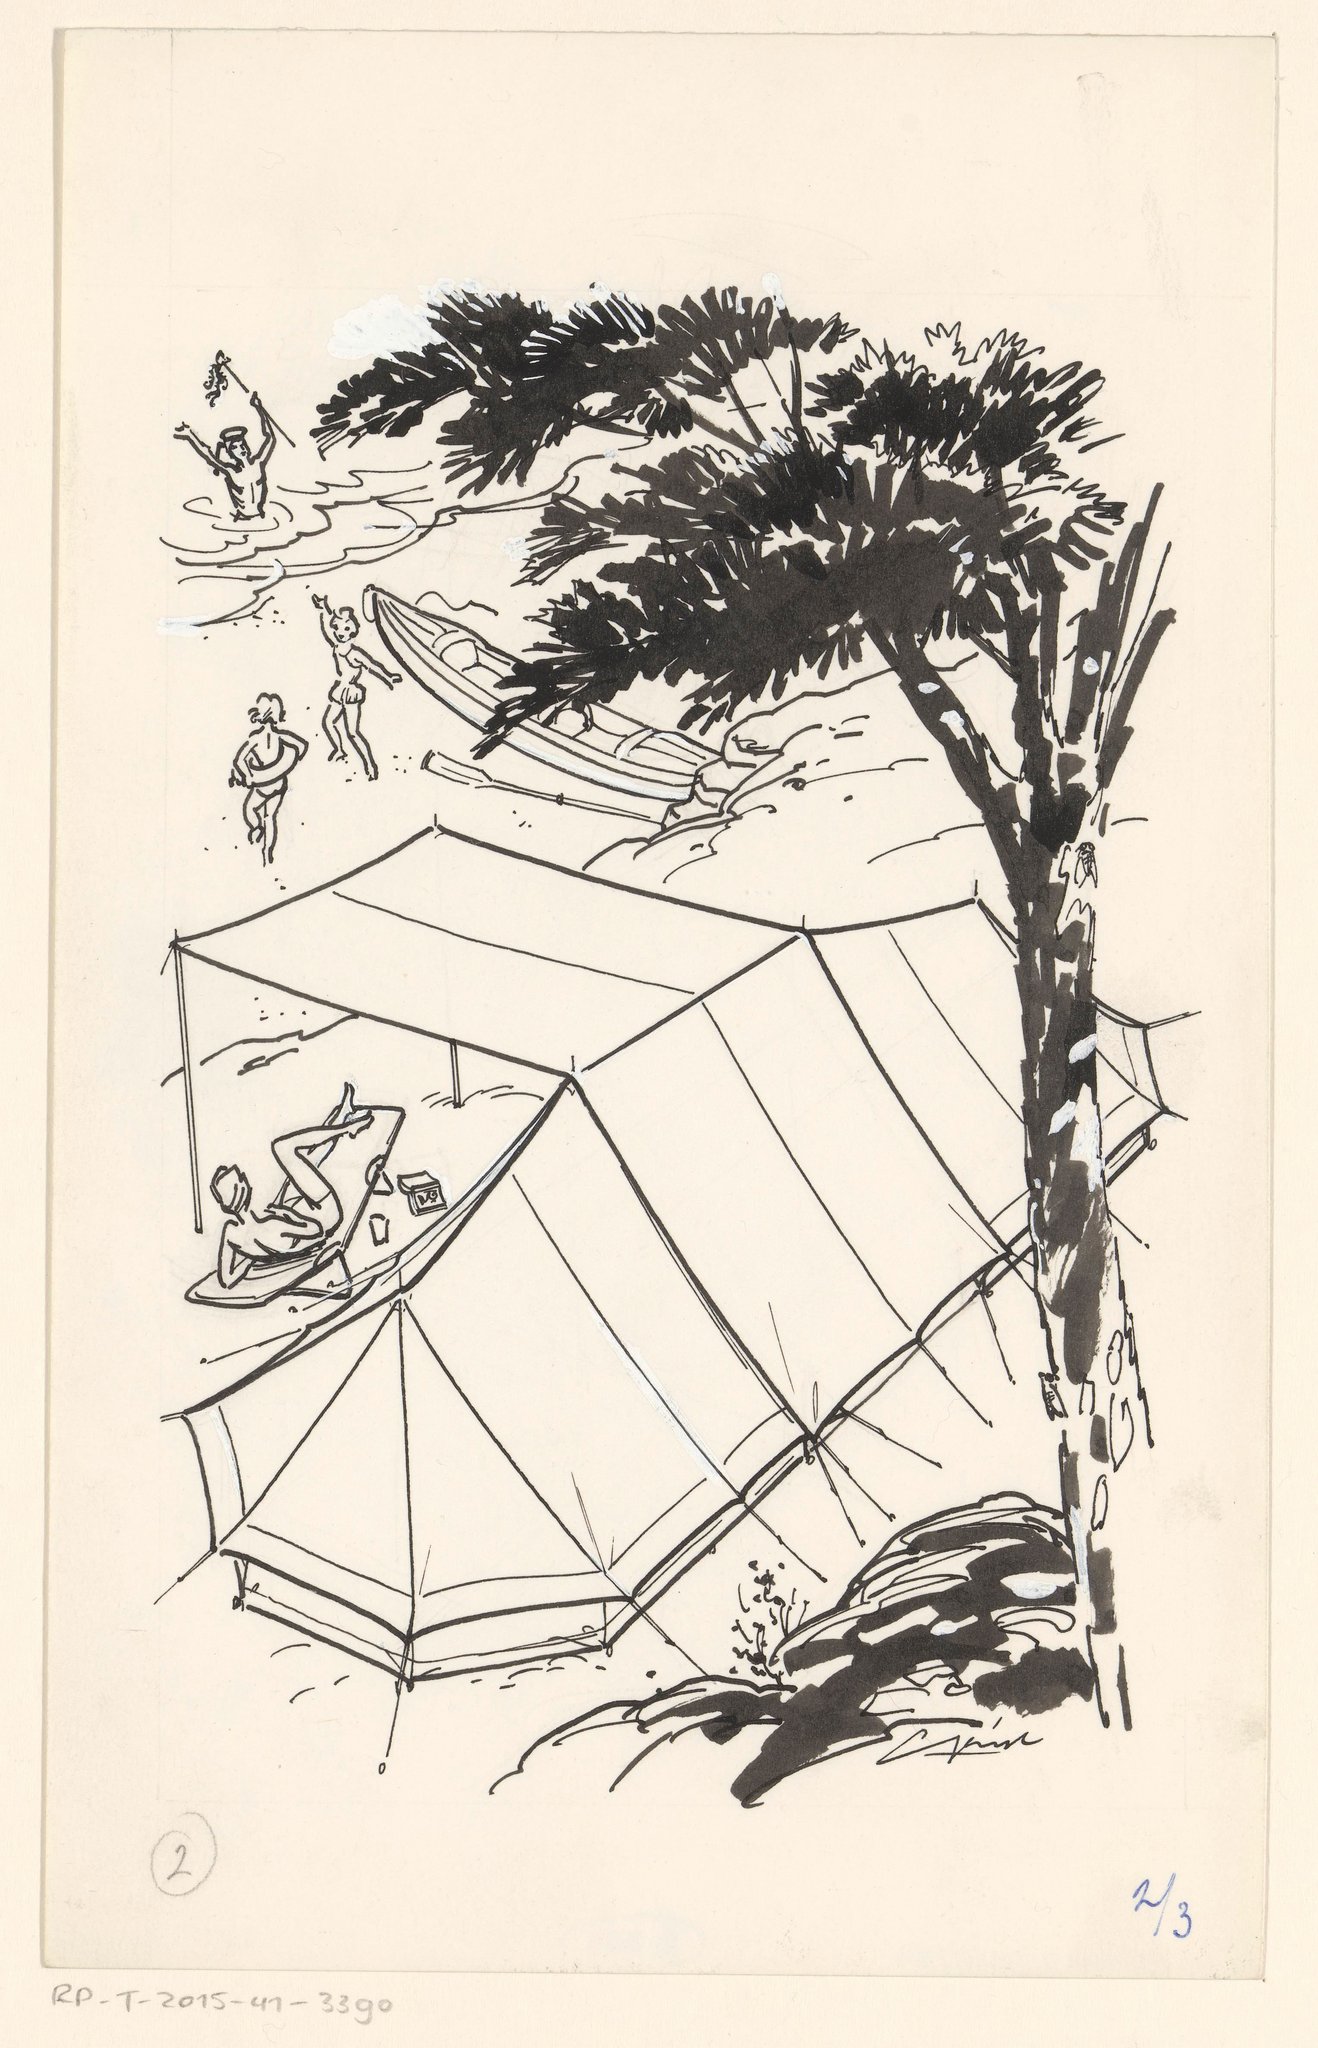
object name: boekillustratie ontwerp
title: Kampeerders aan een waterkant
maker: Anonymous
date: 1930-1970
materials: paint, ink, paper, pencil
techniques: brush, pen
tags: tent, recreation, amusement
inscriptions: signature: ‘Gérard[?]’, number: ‘2’, :, collector's mark: Lugt 2228a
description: Langs een waterkant staat een tent opgezet. Onder de luifel ligt een man op een ligstoel. Drie kinderen vermaken zich in en rond het water met een snorkel, zwemband en kano.